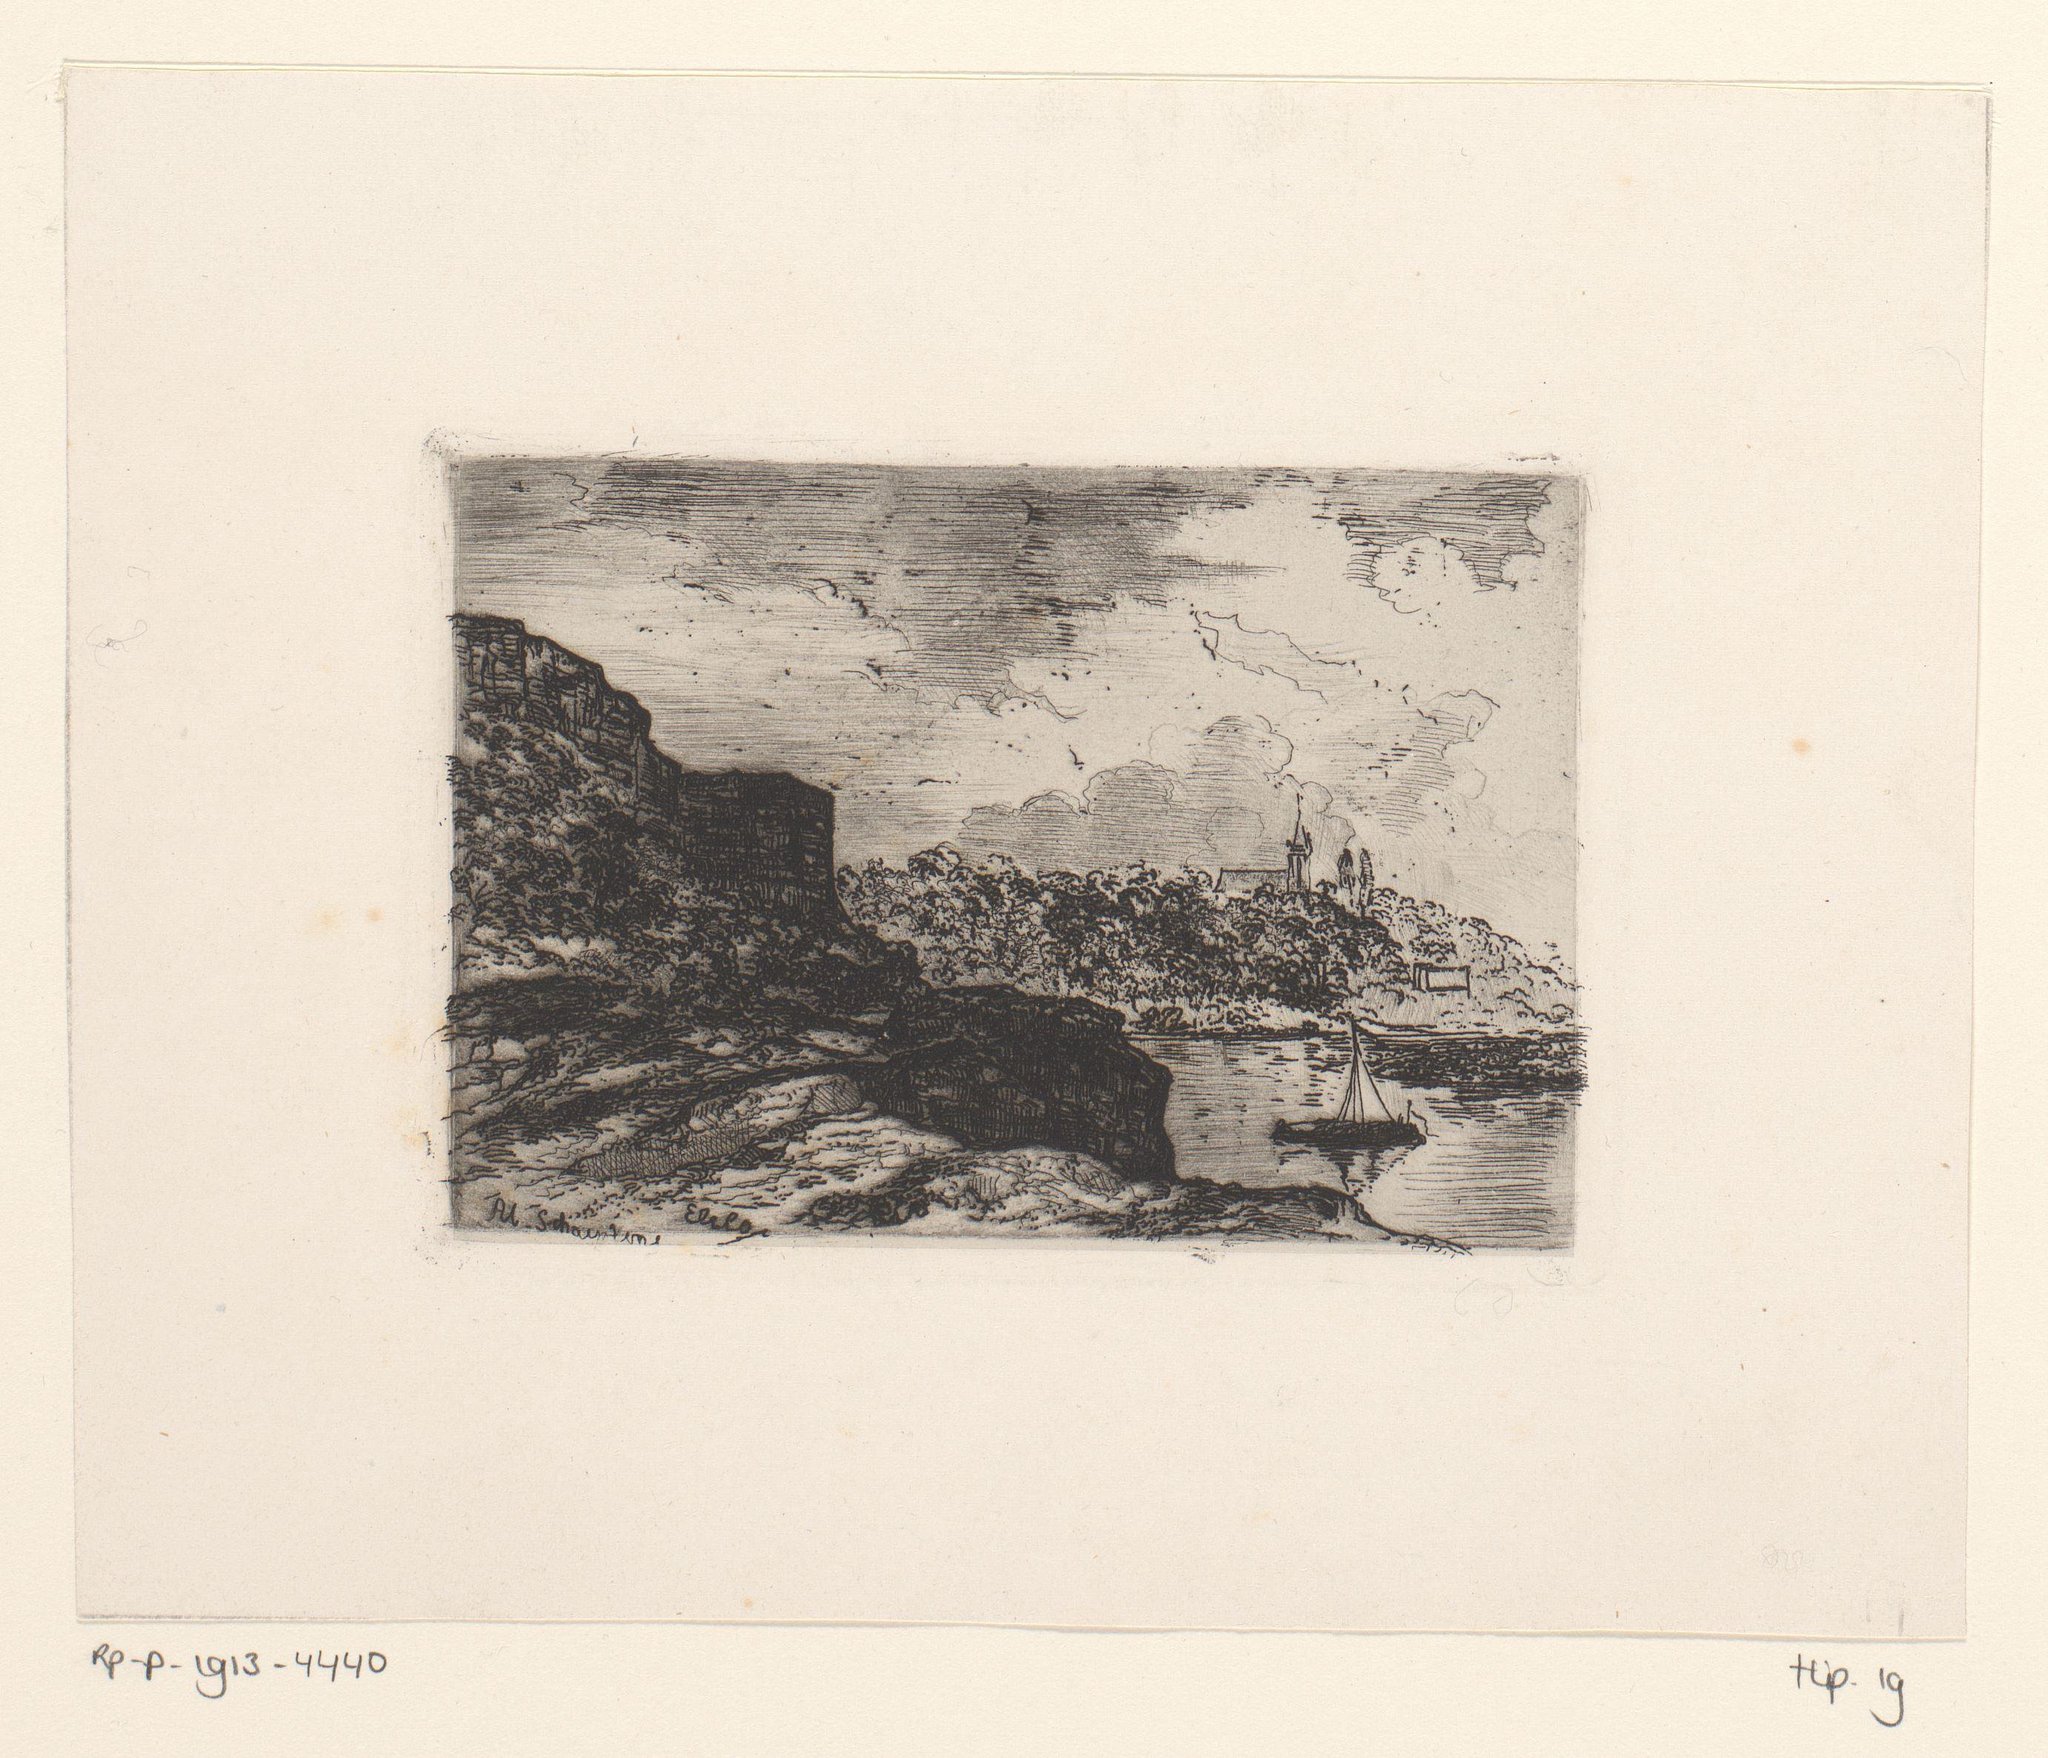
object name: print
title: Elslo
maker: alexander schaepkens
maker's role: draughtsman, print maker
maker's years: 1815-1899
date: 1830-1899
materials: paper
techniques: etching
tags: rocky coast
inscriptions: collector's mark: Lugt 2228